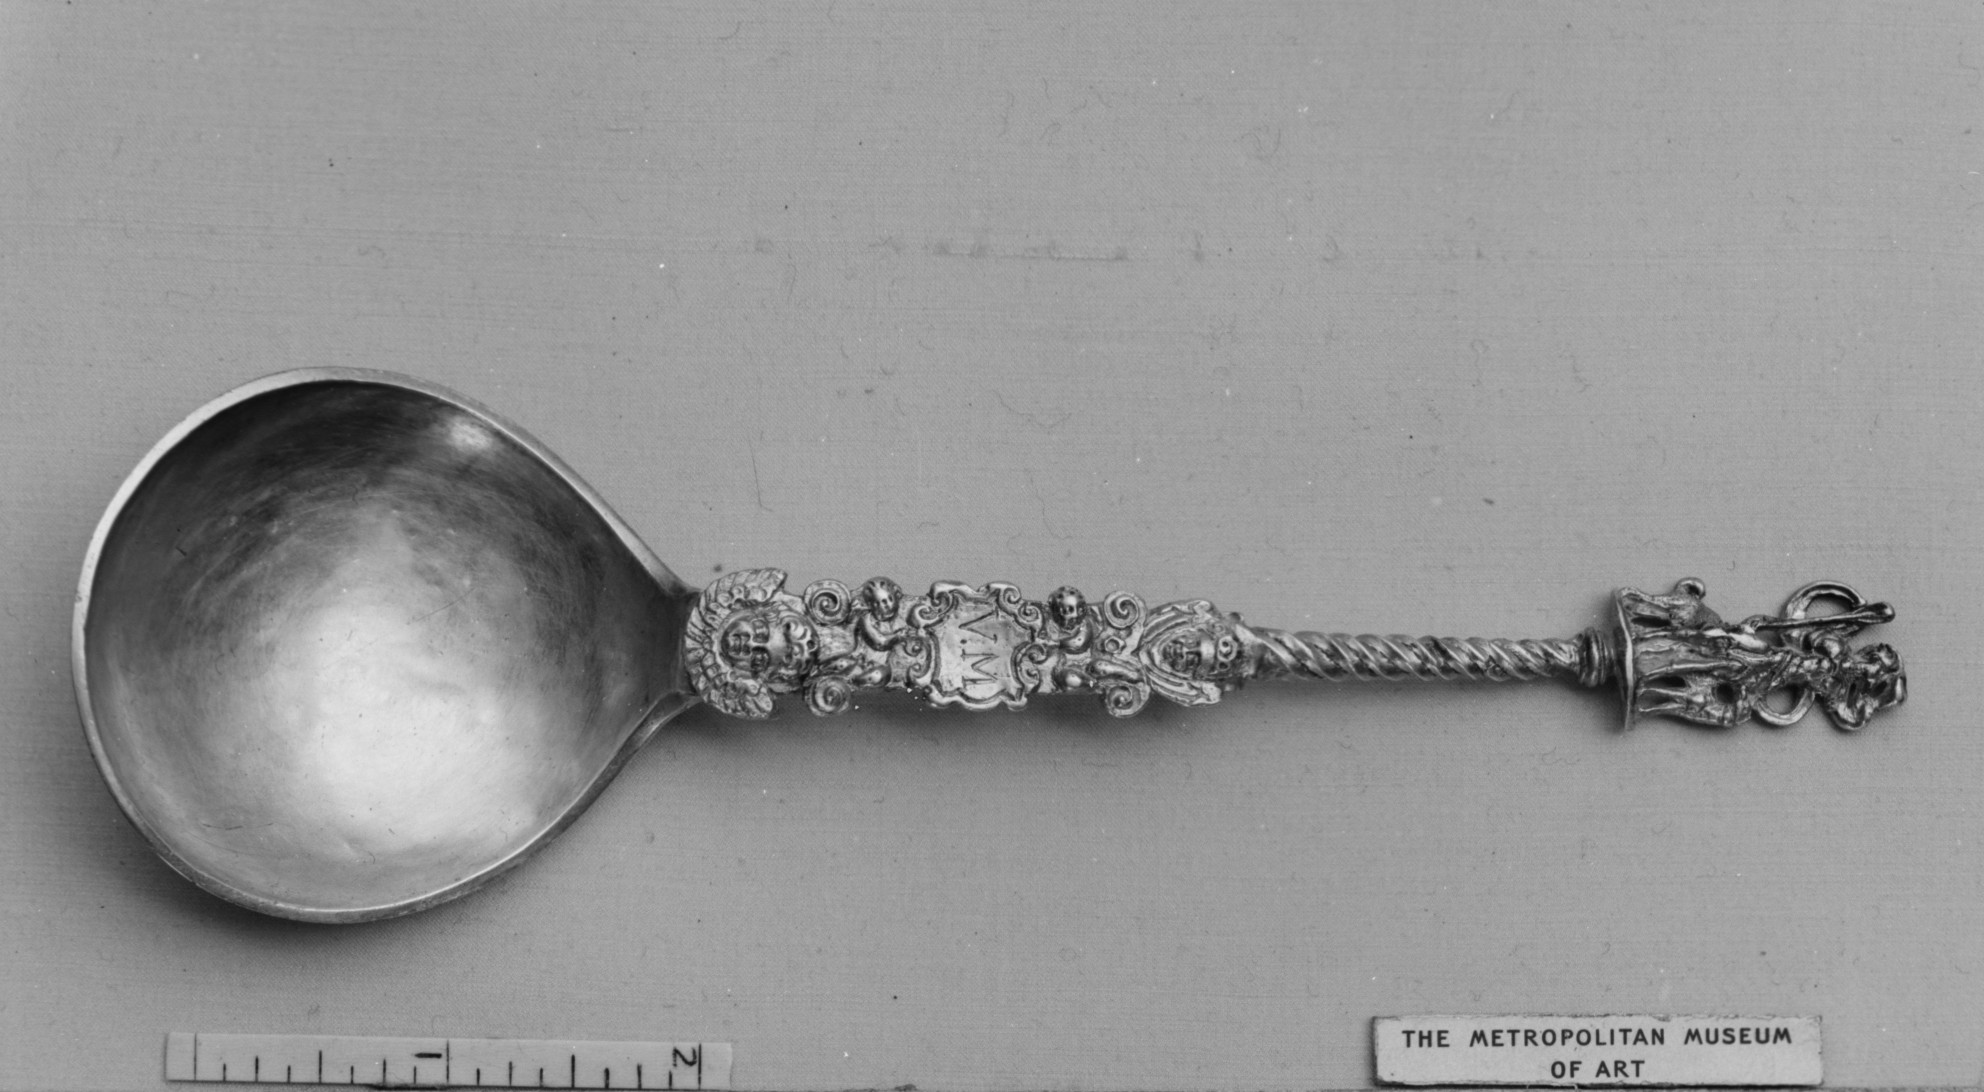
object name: spoon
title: Figure-top spoon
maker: tonnies dierssen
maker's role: maker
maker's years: 1490-1590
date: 1560-1590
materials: silver gilt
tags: human figures,animals